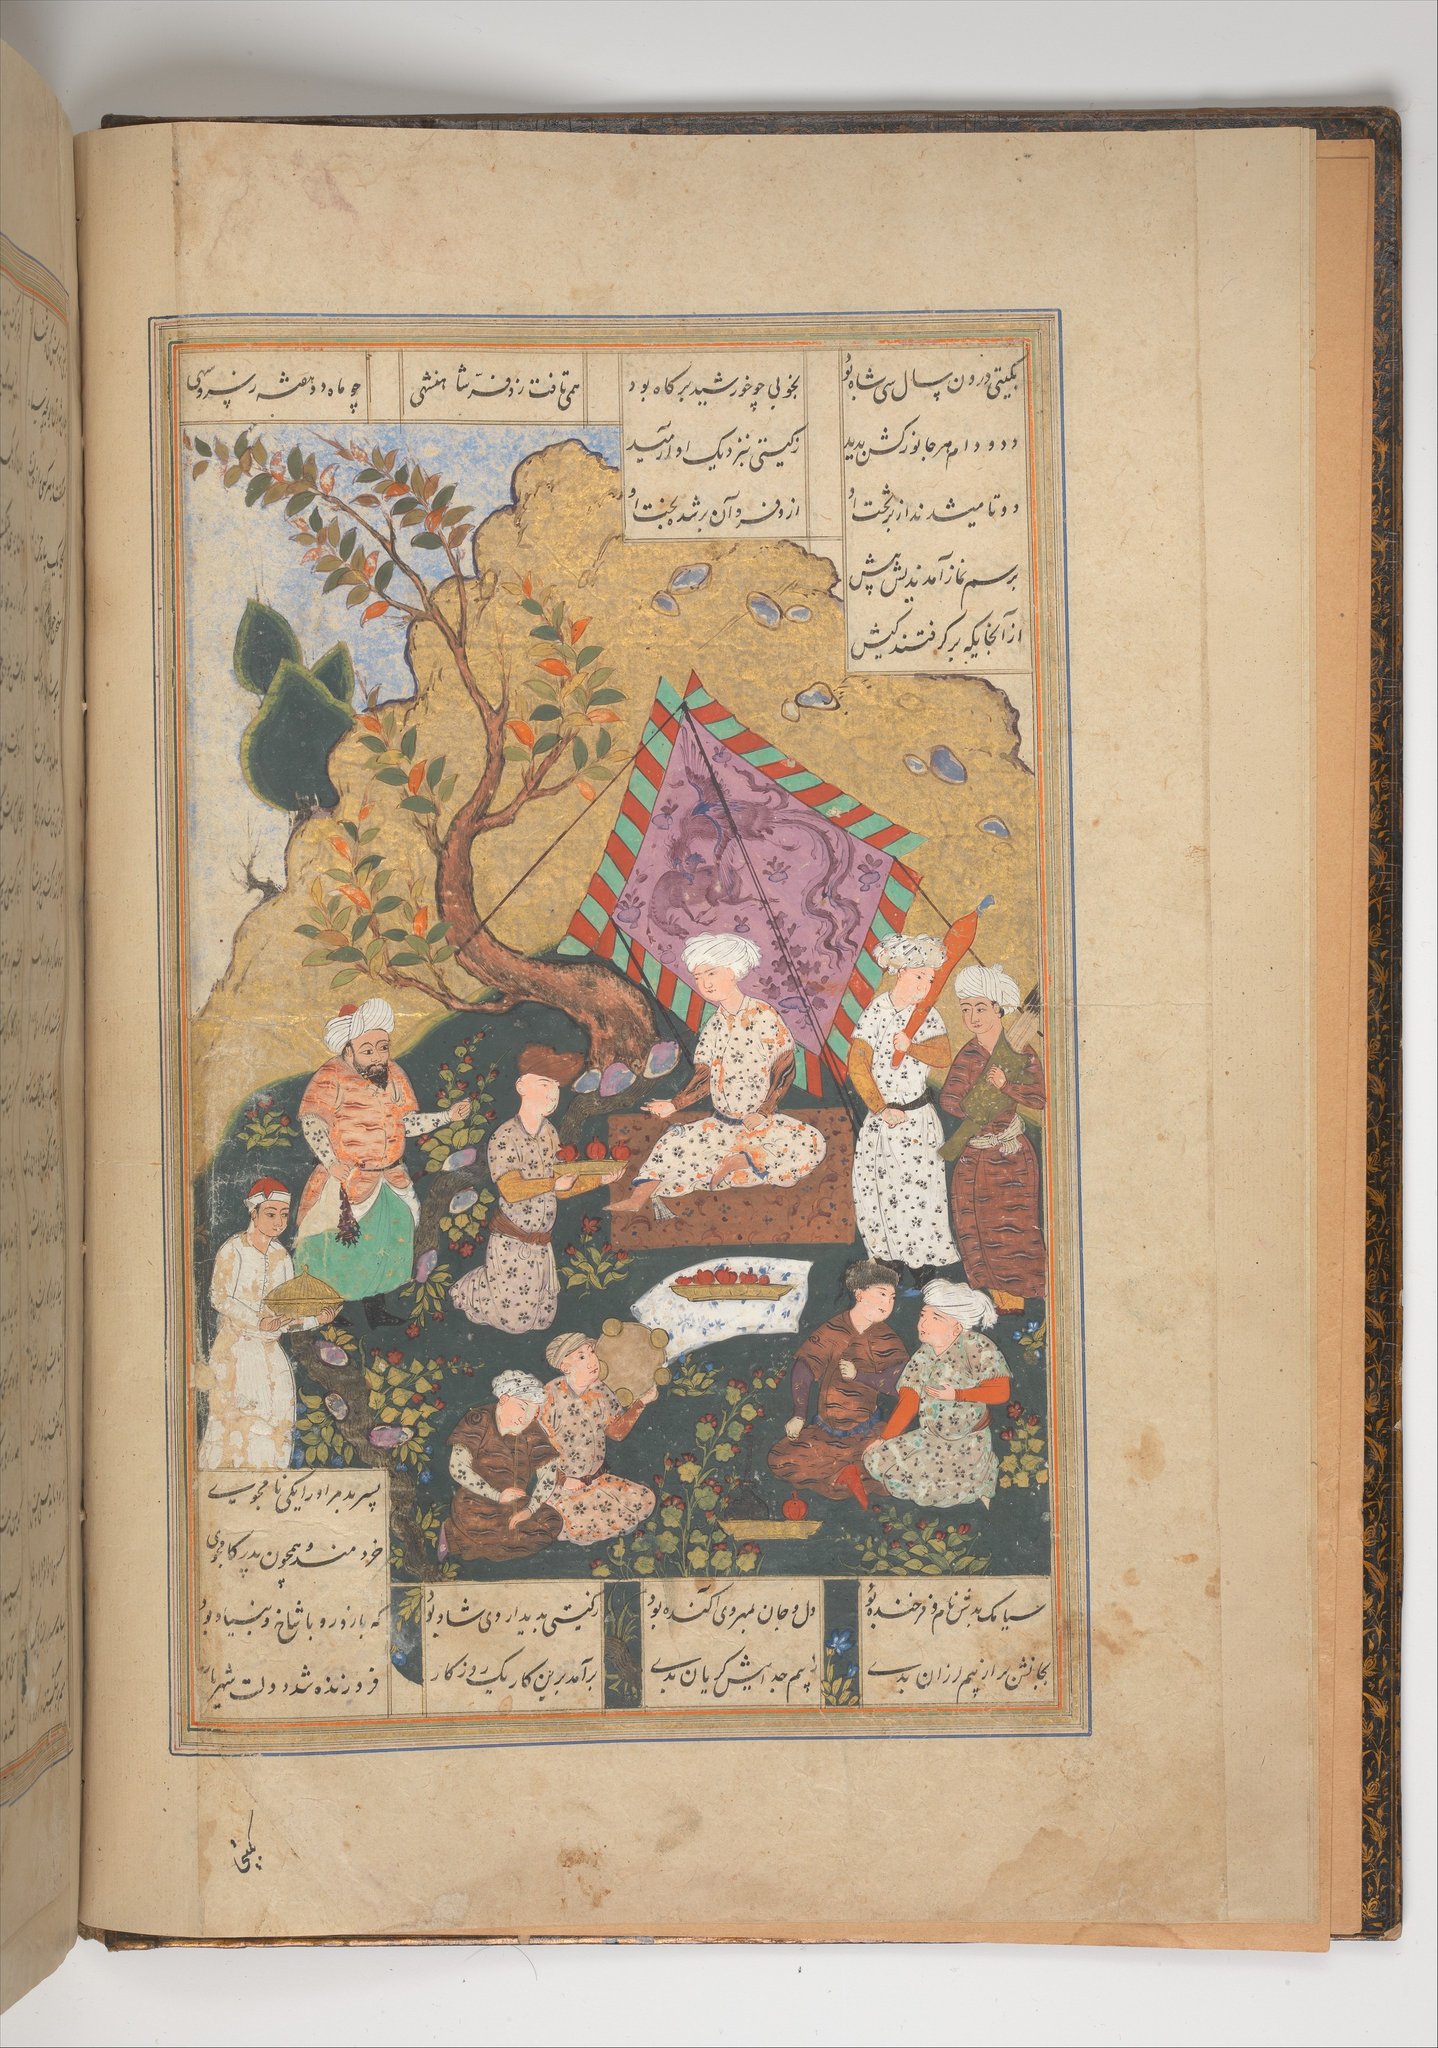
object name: illustrated manuscript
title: Shahnama (Book of Kings) of Firdausi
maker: shah muhammad of sabzavar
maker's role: calligrapher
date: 1601-1700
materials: gold, ink, paper, watercolor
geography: iran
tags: men,women